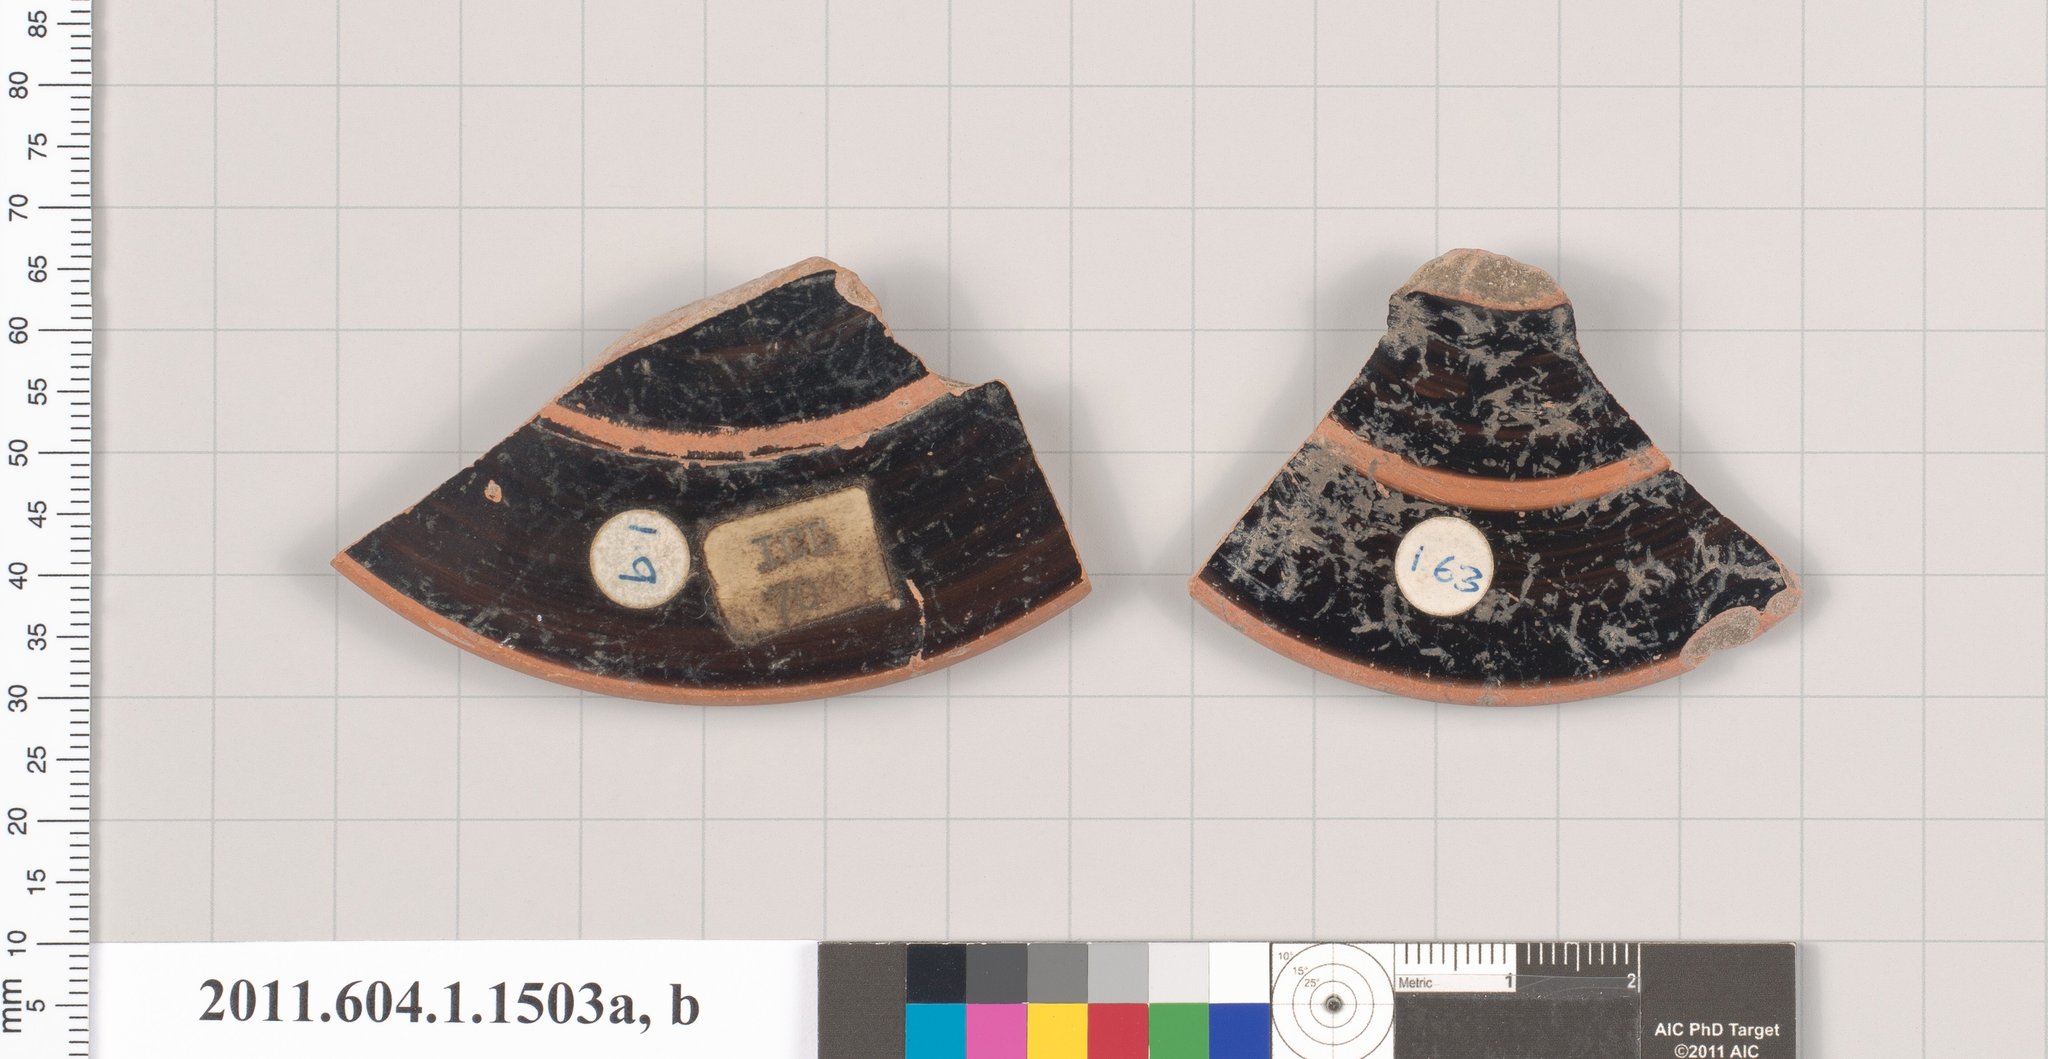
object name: kylix fragment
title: Terracotta fragments of kylikes (drinking cups)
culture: greek, attic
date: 500-401 BCE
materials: terracotta